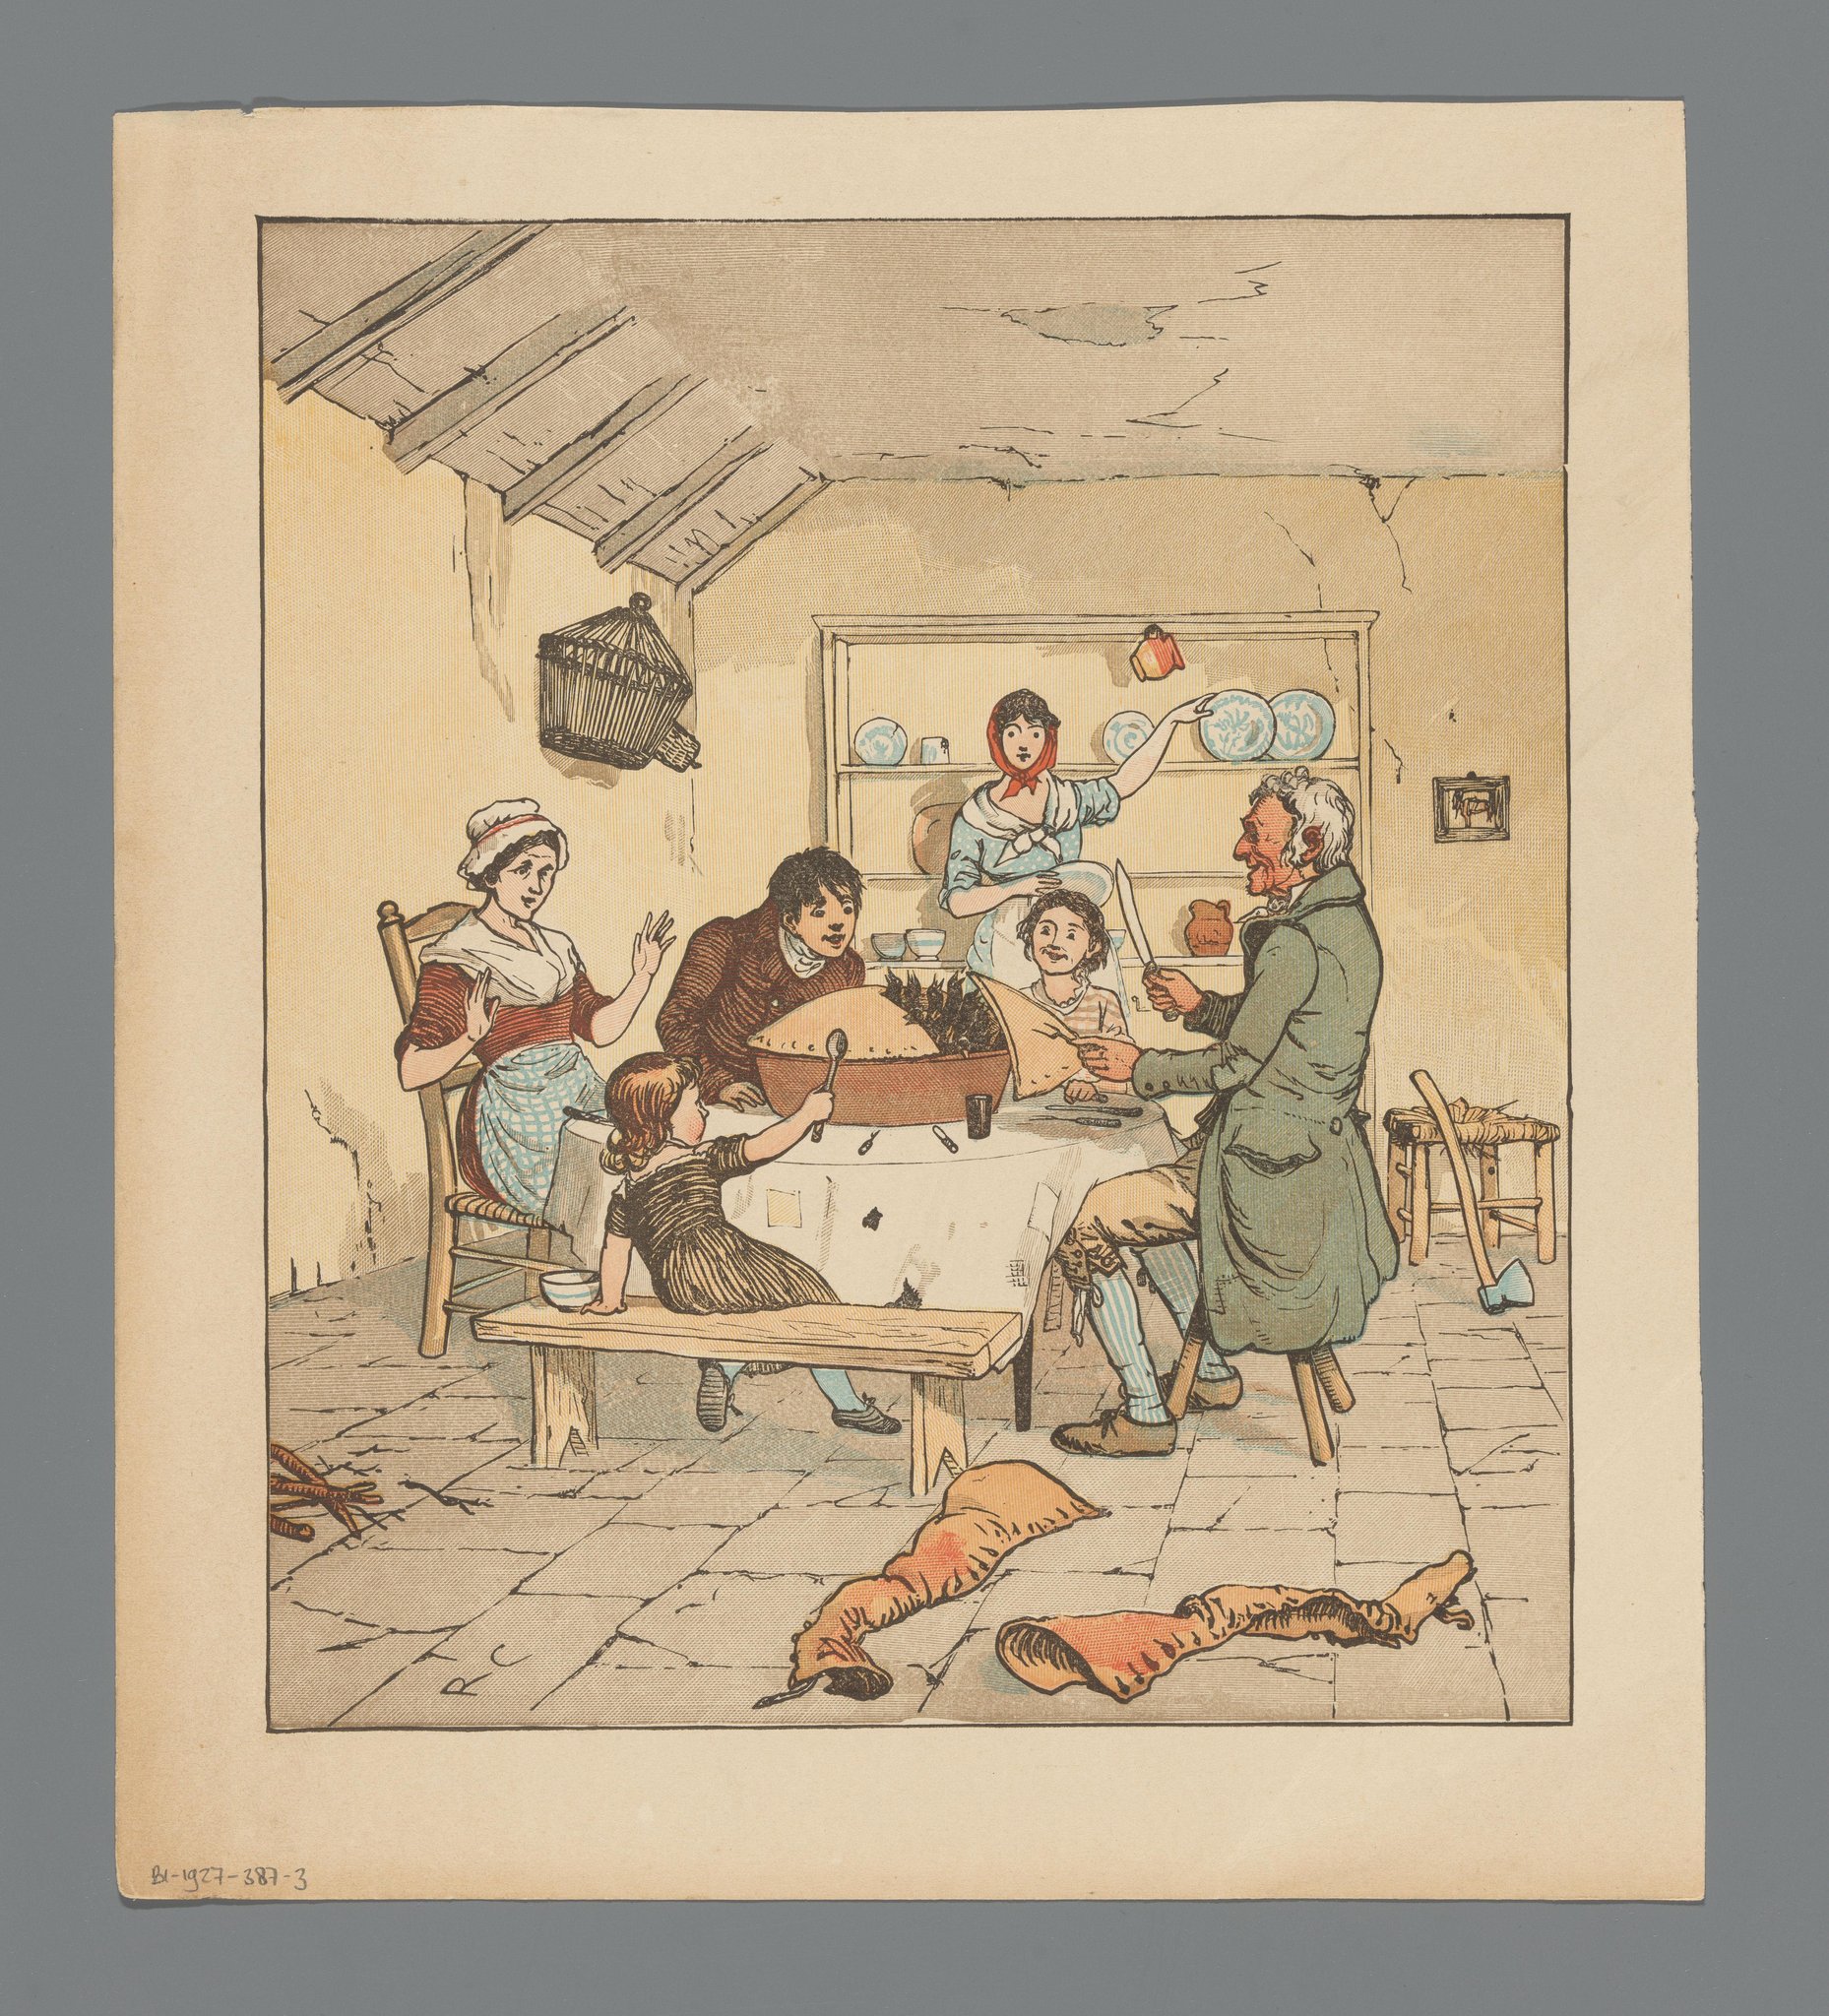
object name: print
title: Familie aan tafel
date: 1880-1927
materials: paper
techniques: wood engraving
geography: london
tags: pie, family life at home, eating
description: Prent uit: Sing a song of sixpence. Londen: George Routledge & Sons, 1880. Of uit een later gepubliceerde (gebundelde) uitgave.